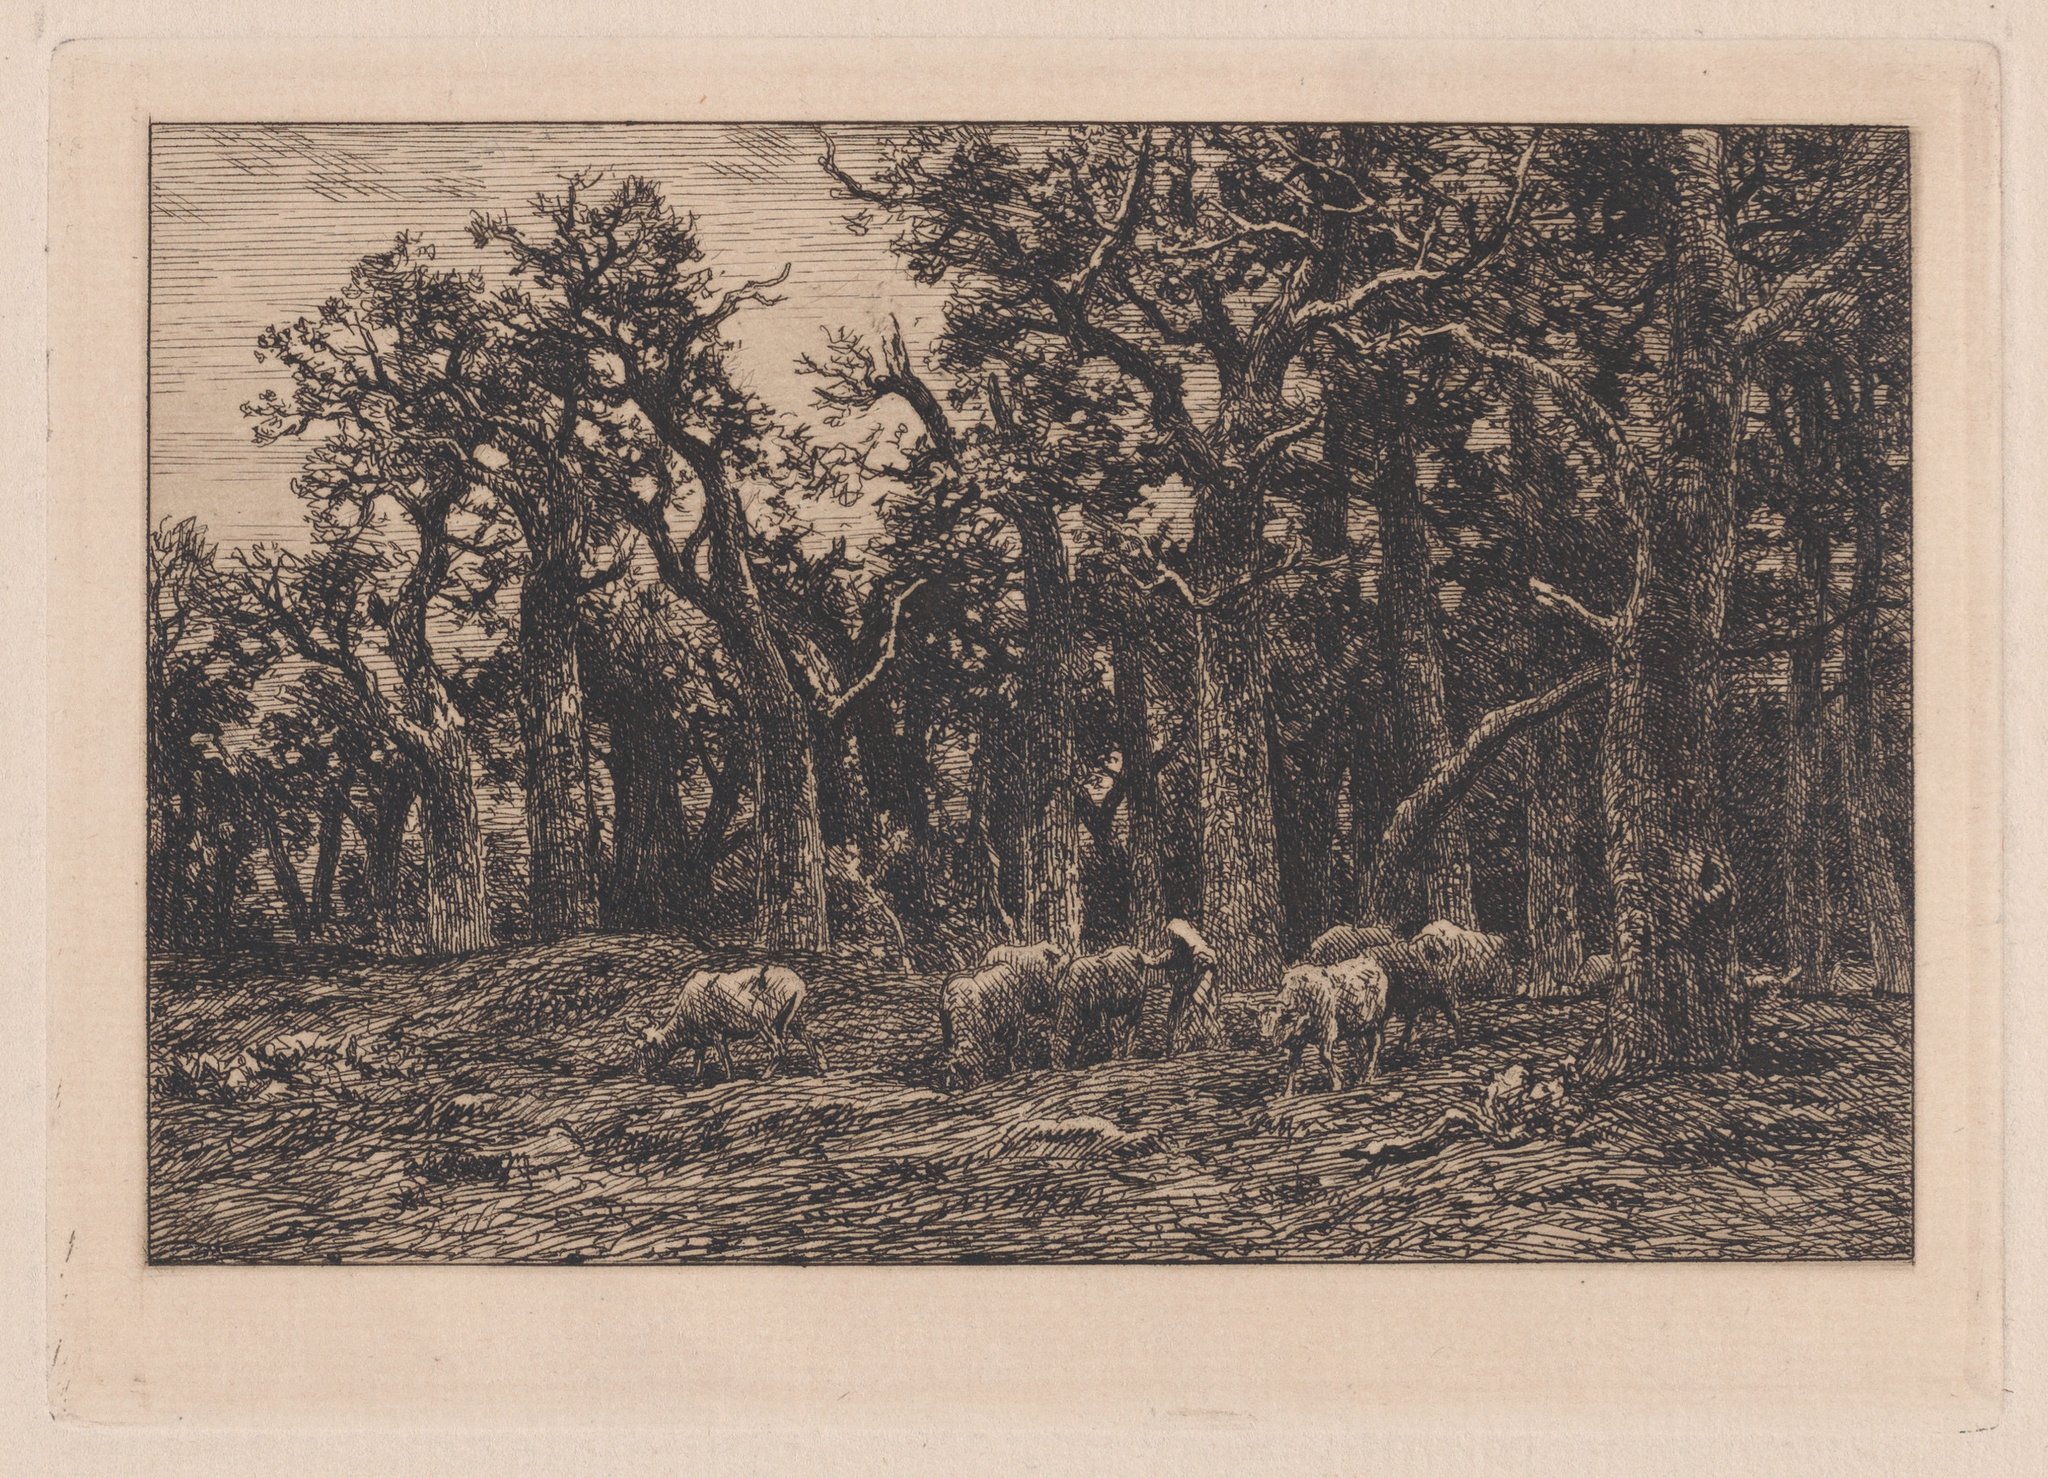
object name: print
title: Woman driving a herd of cows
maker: charles émile jacque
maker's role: artist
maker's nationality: french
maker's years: 1813-1894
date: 1801-1900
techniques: etching